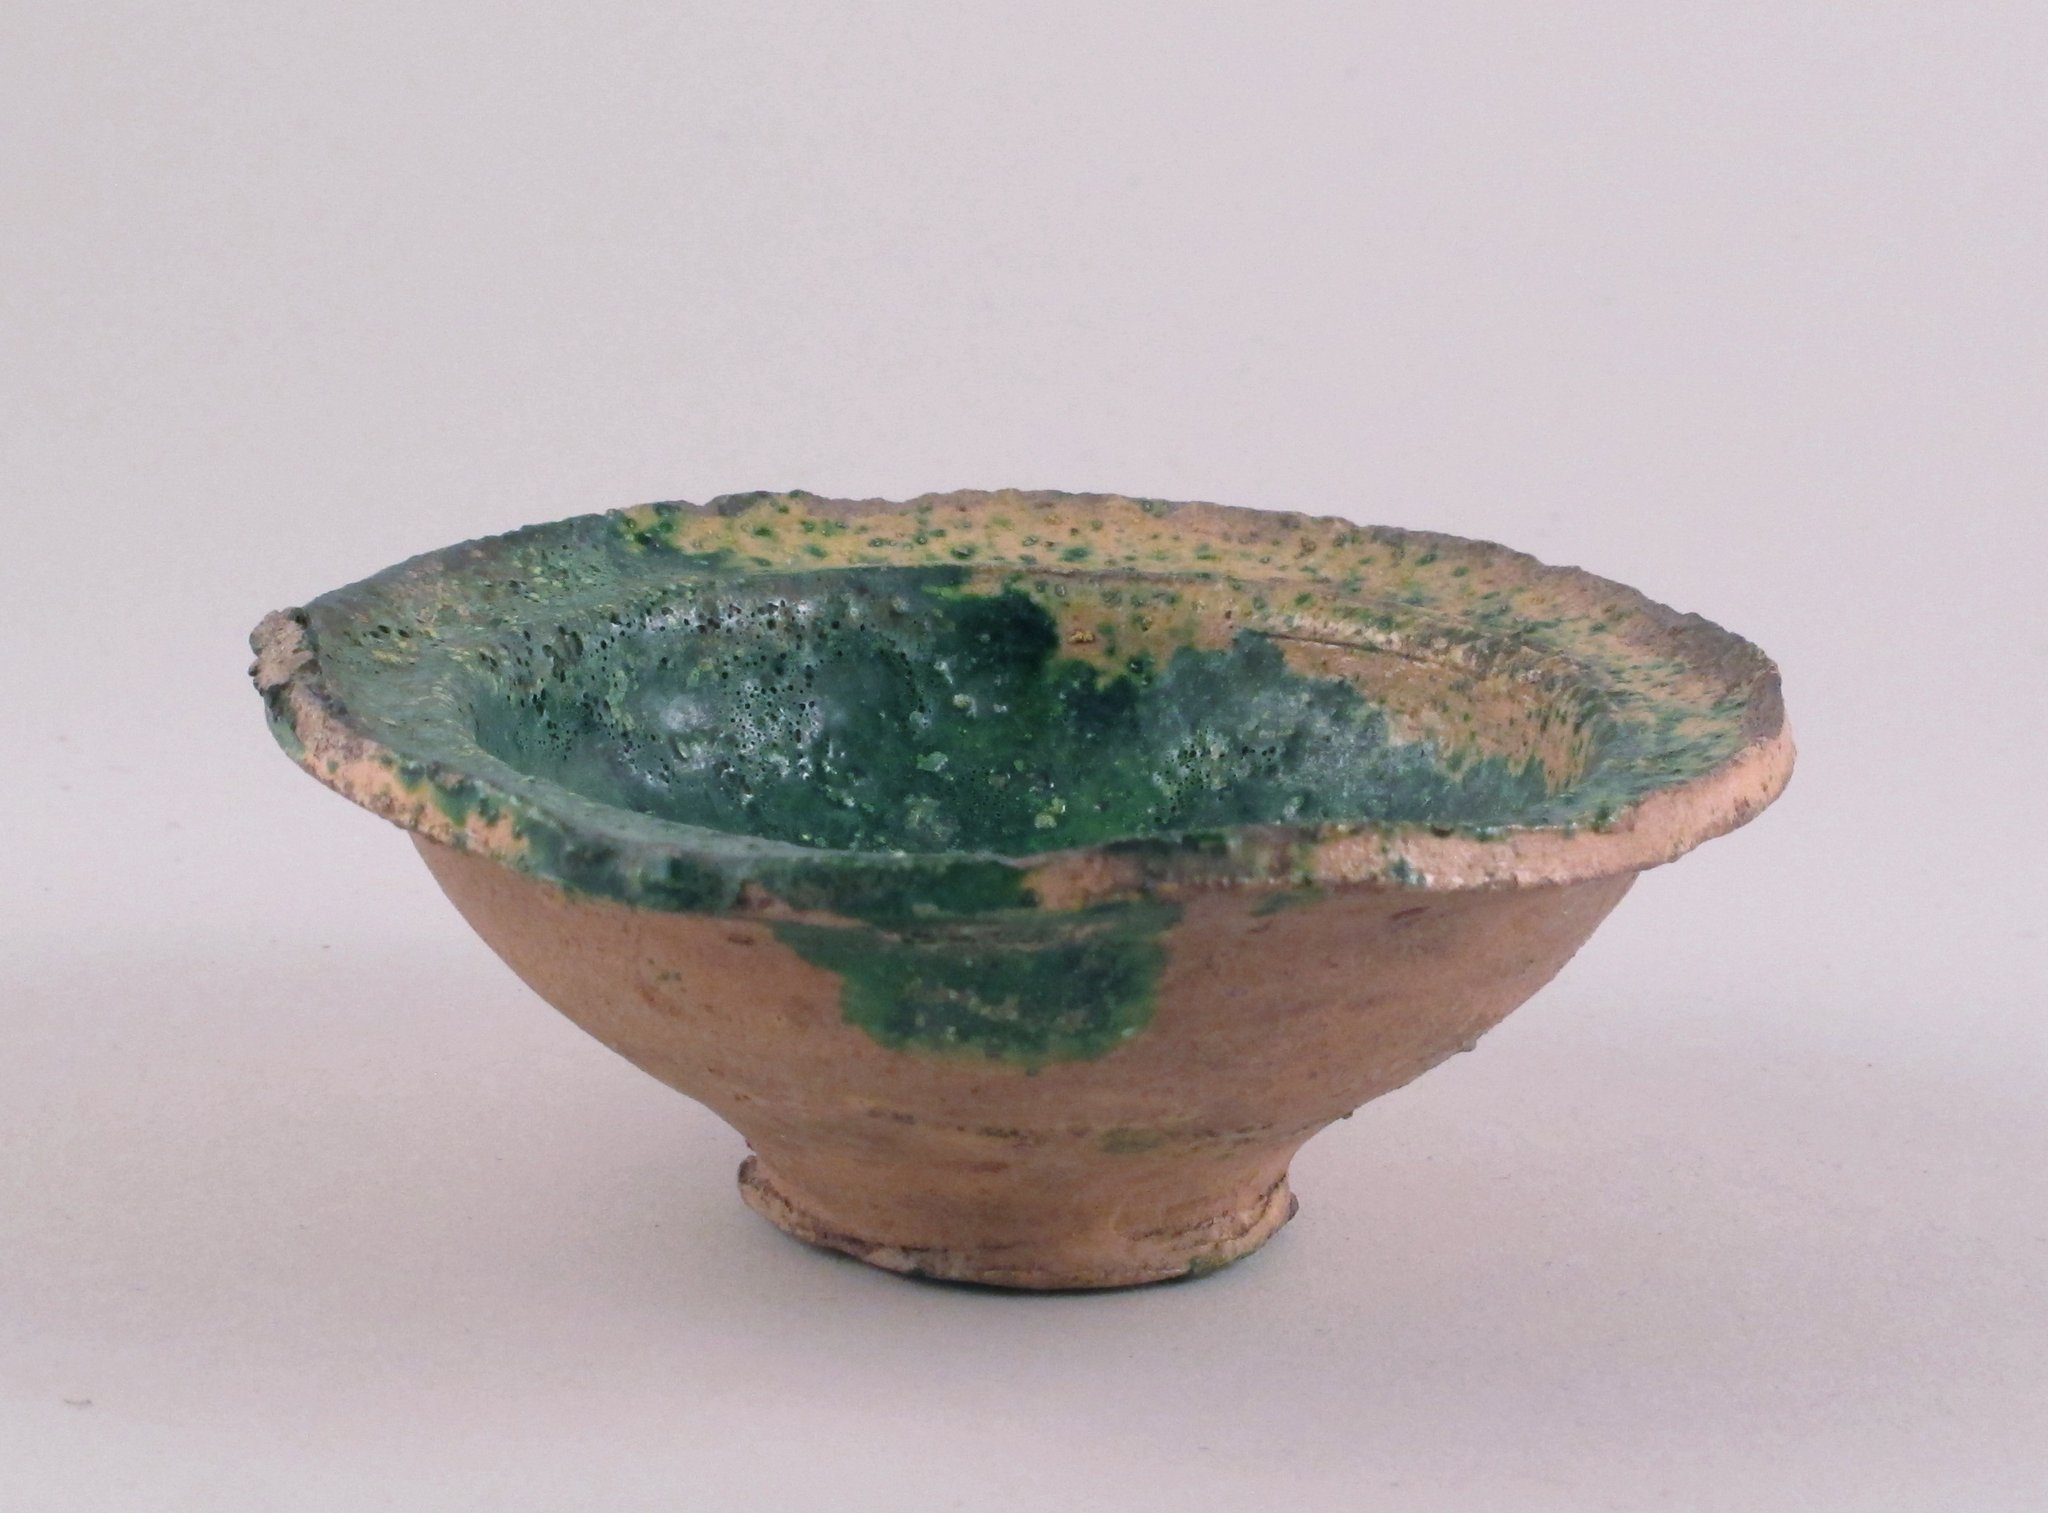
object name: saucer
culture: roman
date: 670 BCE-330 CE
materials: terracotta